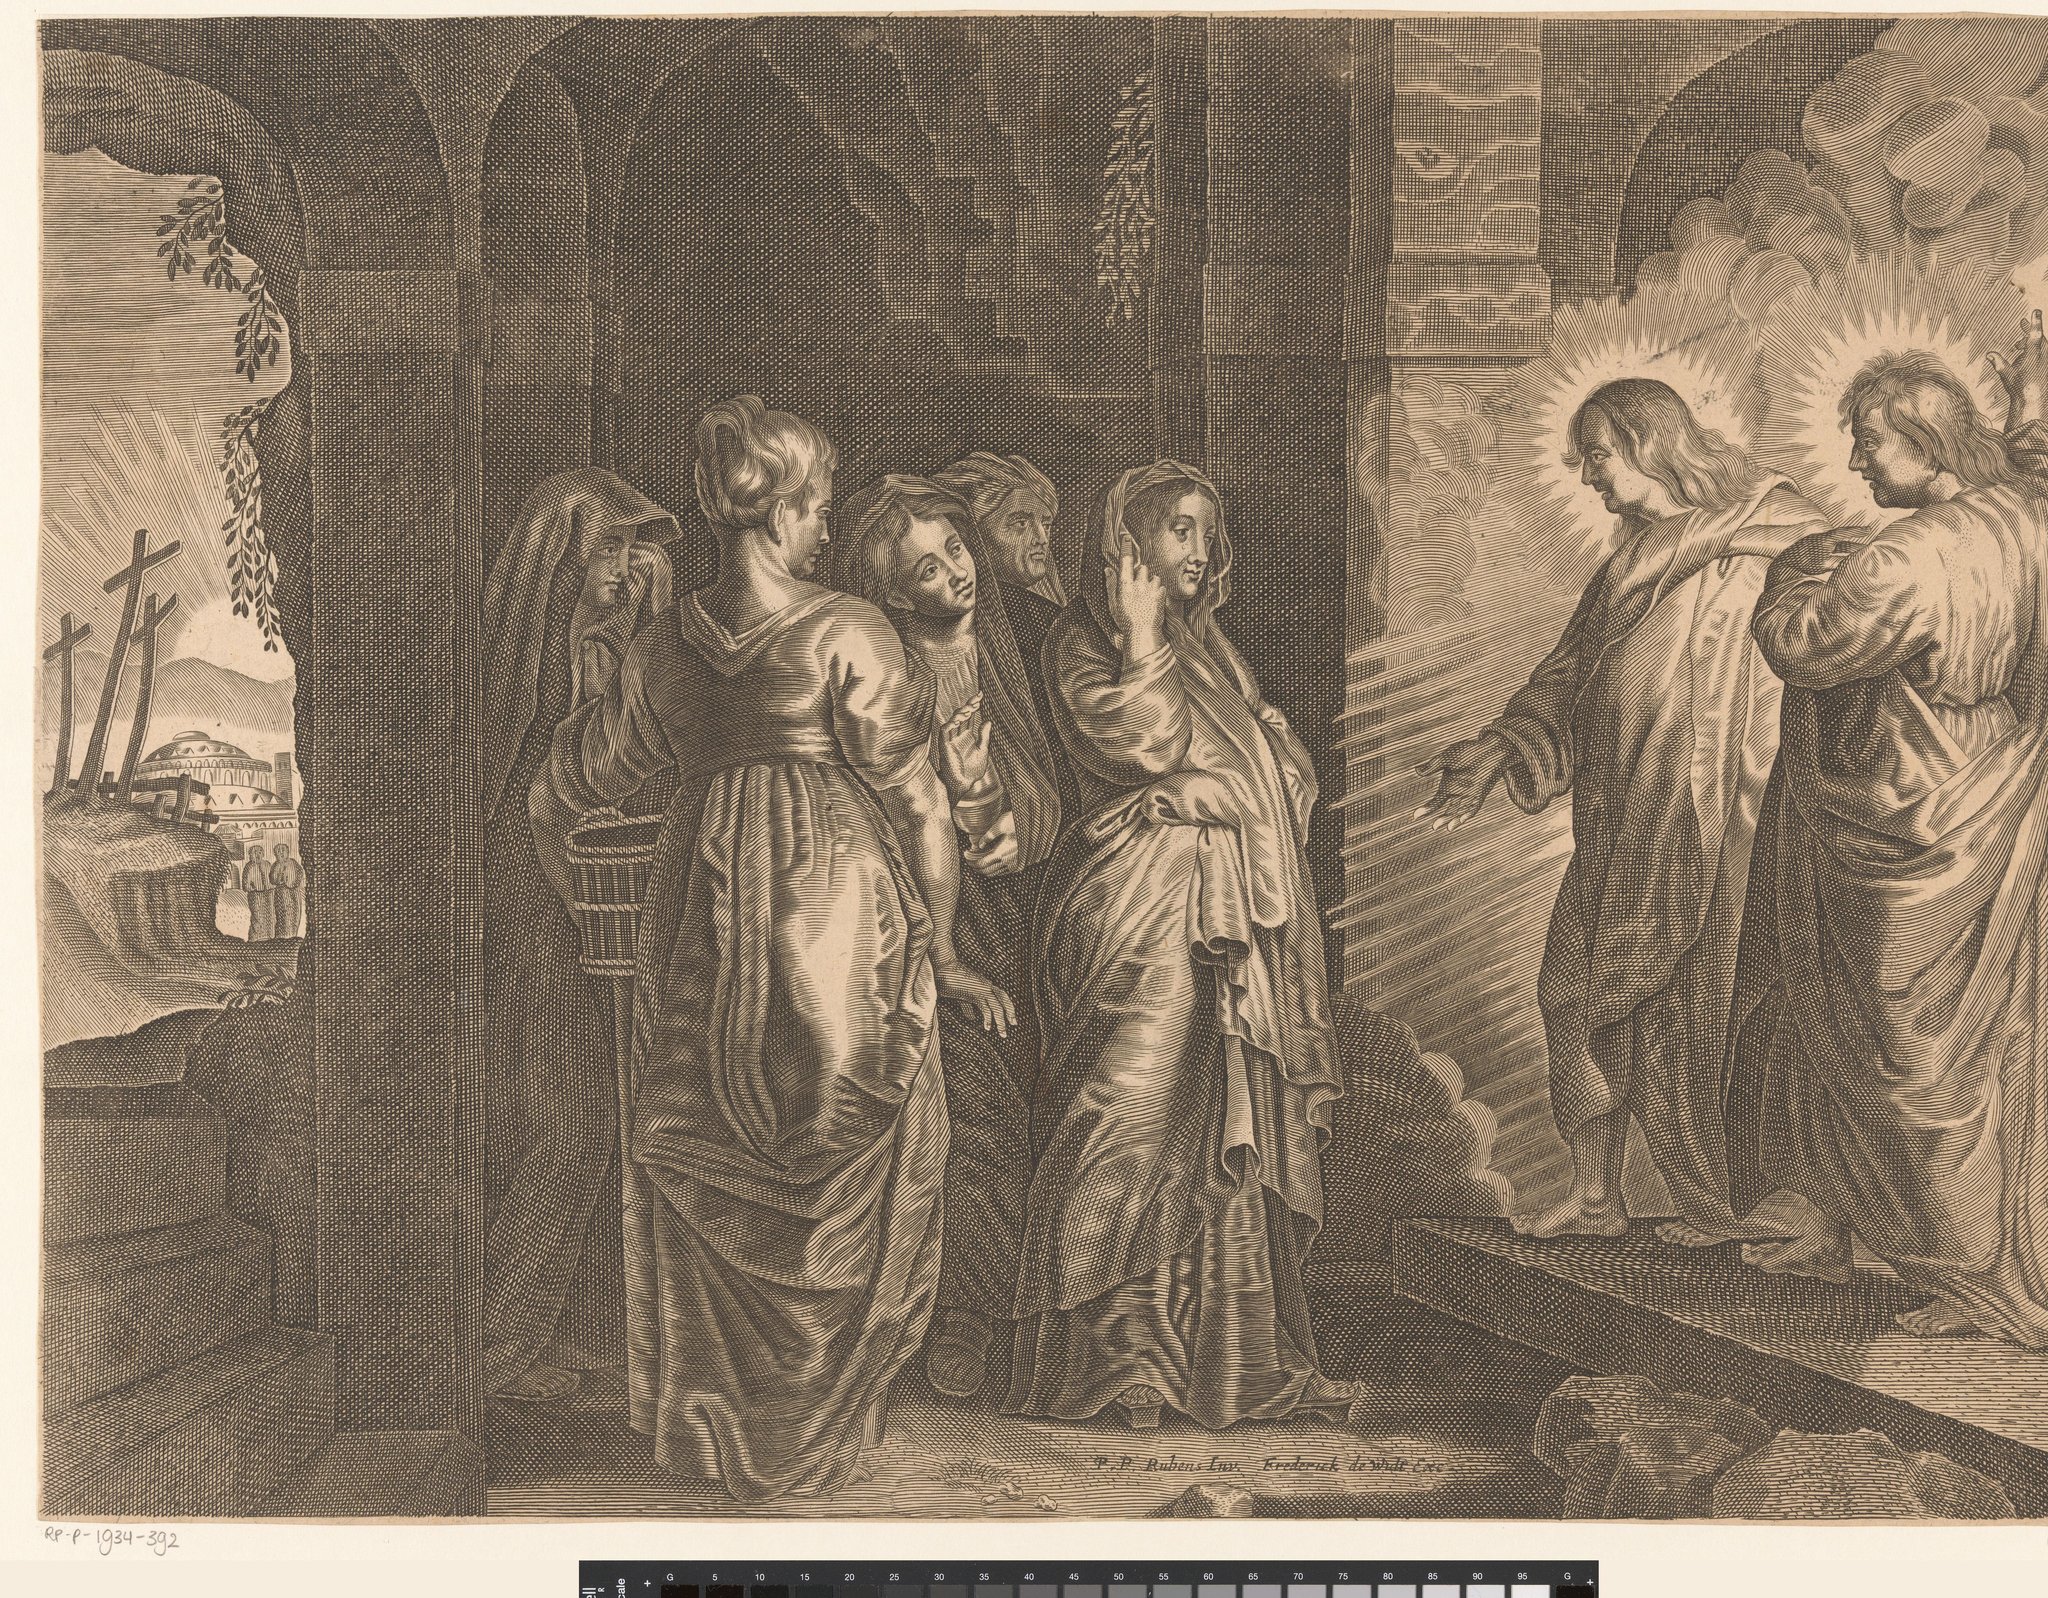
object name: print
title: Heilige vrouwen bij het graf van Christus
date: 1639-1706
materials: paper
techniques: engraving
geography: amsterdam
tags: the holy women (the three maries) on their way to or at the tomb, to anoint christ's body, angel(s) addressing the holy women ~ resurrection of christ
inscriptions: collector's mark: Lugt 2228, number: ‘10’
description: De heilige vrouwen staan na de opstanding van Christus als eerste bij het graf. Ze staan vol ontzag voor twee mannen (mogelijk engelen) die een verblindend licht uitstralen. Op de achtergrond links de drie kruisen op Golgota.